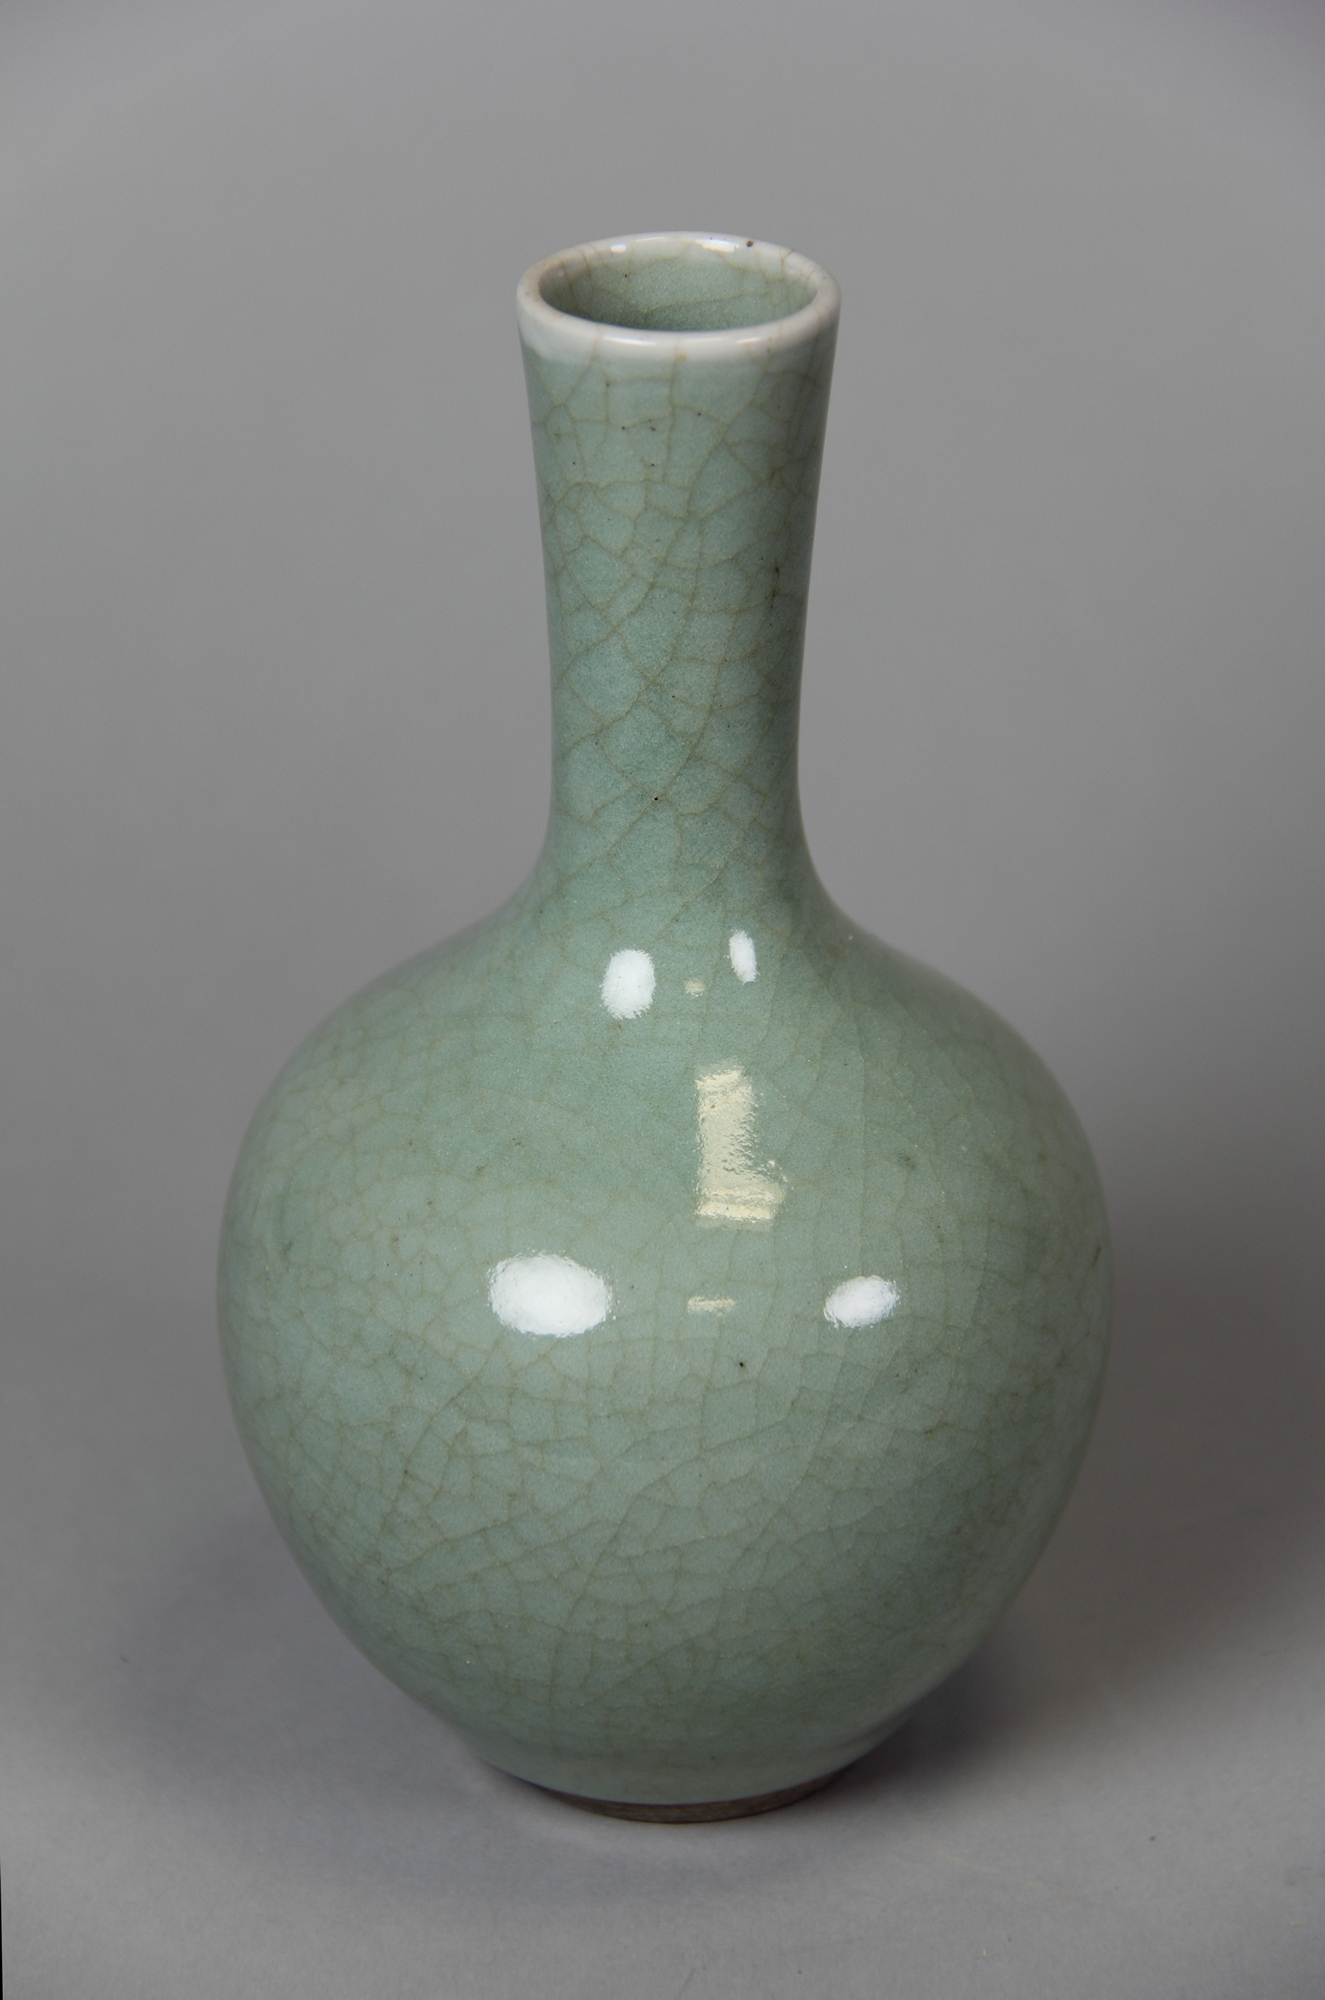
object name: bottle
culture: chinese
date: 1736-1795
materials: porcelain